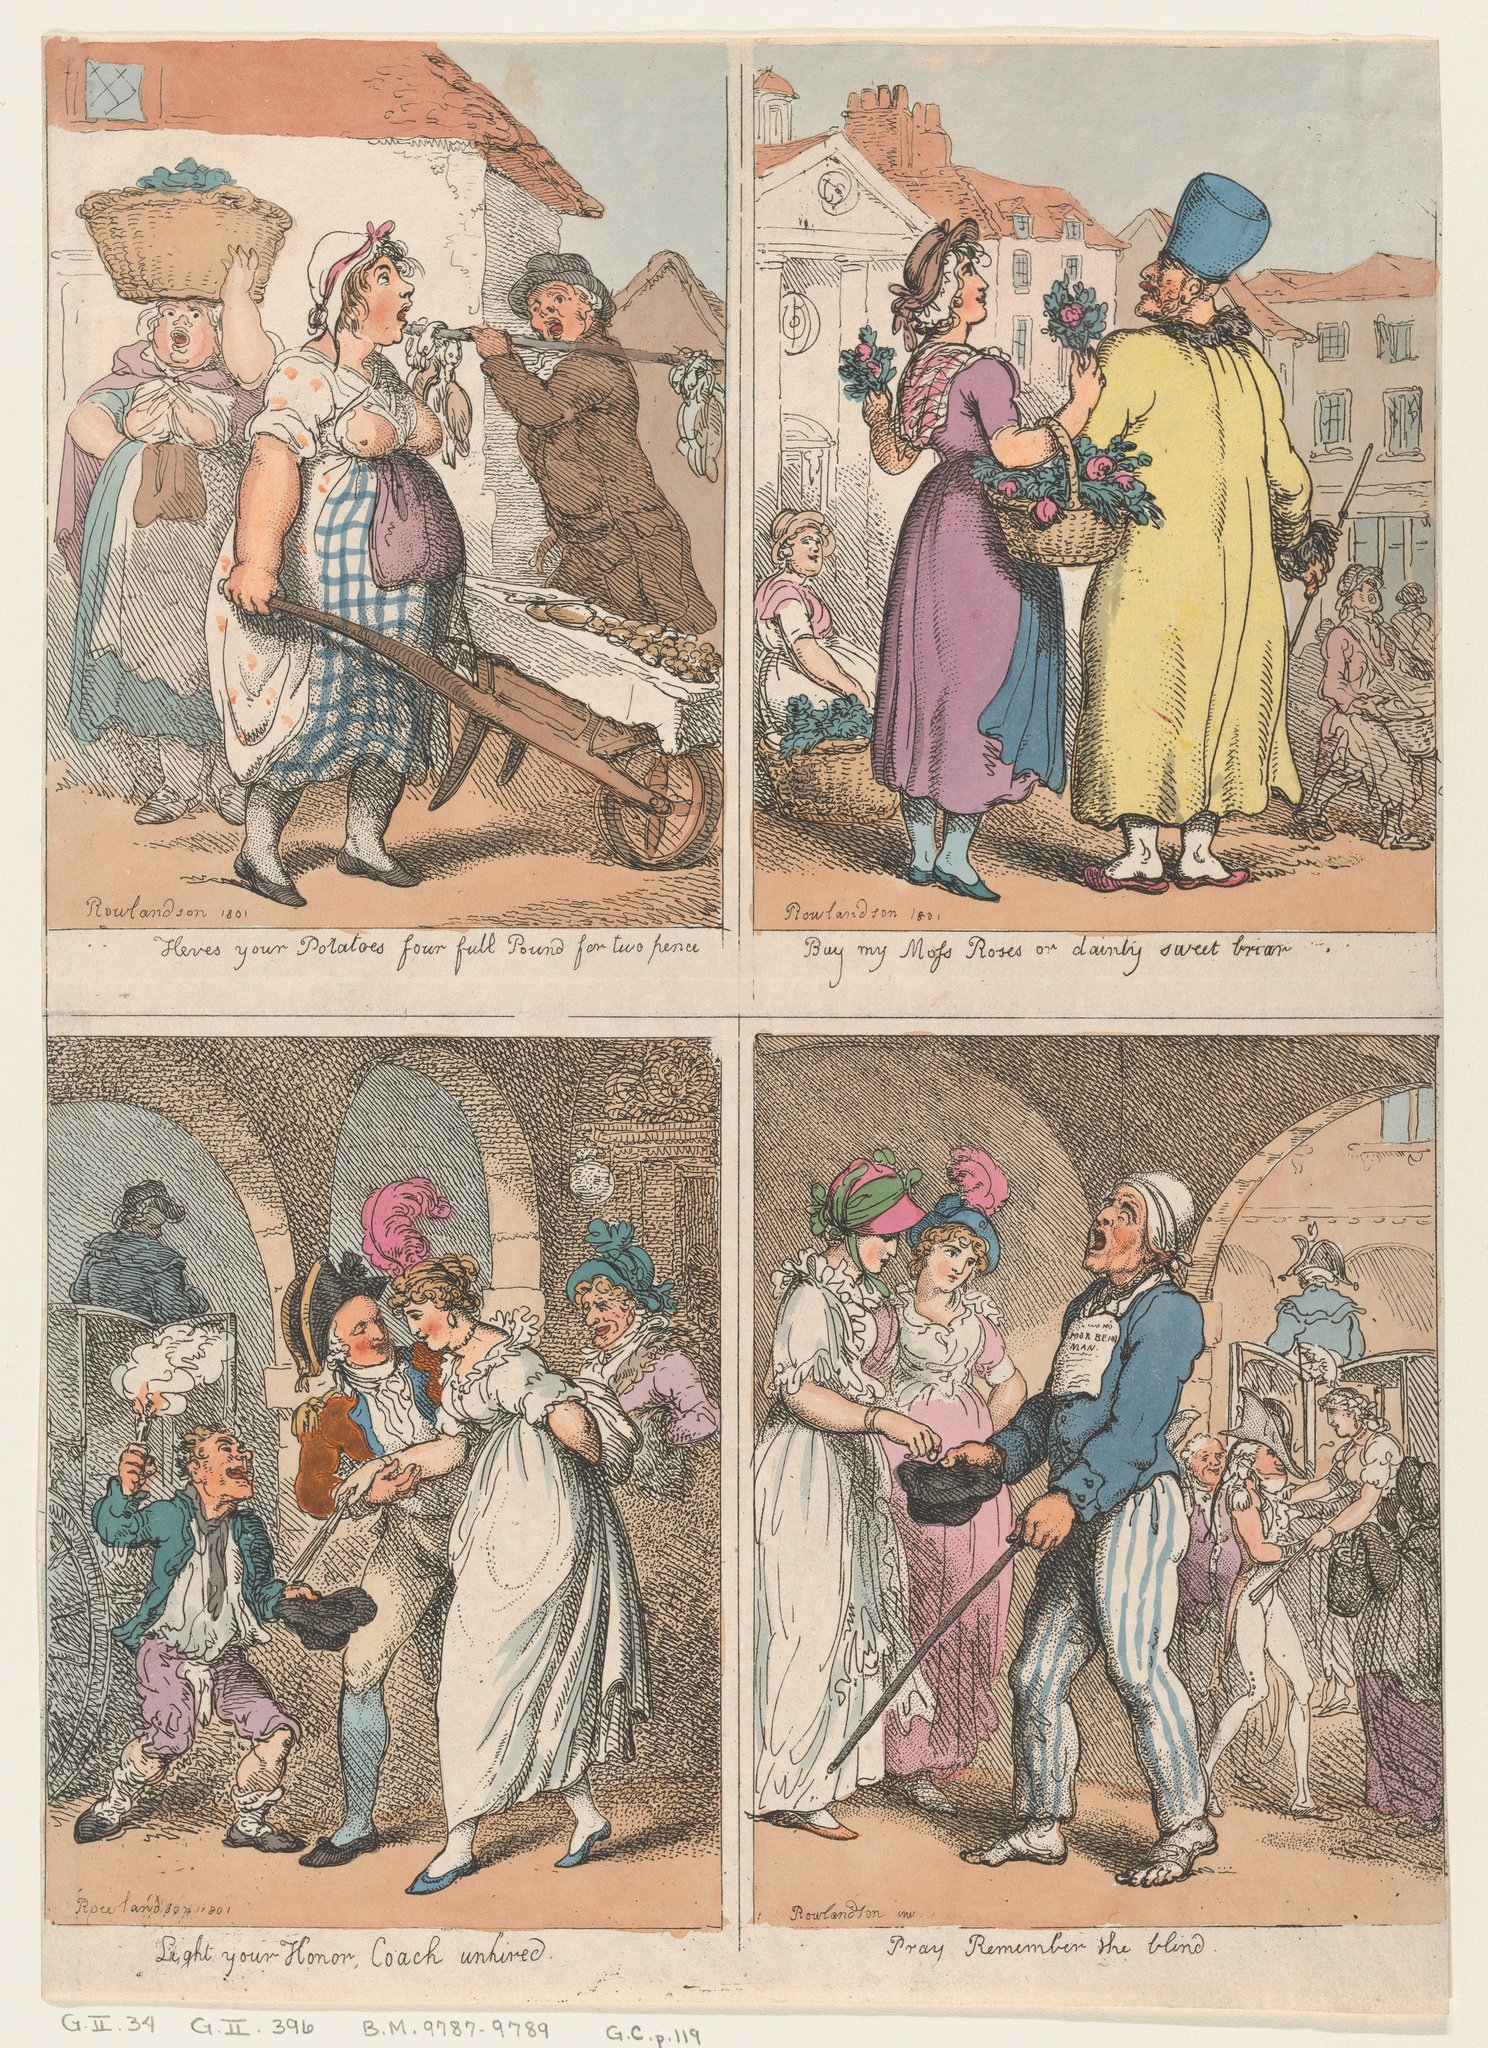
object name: print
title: Four Scenes from "Cries of London" Series: Here's your Potatoes...; Buy my Moss Roses...; Light your Honor; Pray Remember the Blind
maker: thomas rowlandson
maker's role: artist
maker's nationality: british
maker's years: 1757-1827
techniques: etching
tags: men,women,roses,working